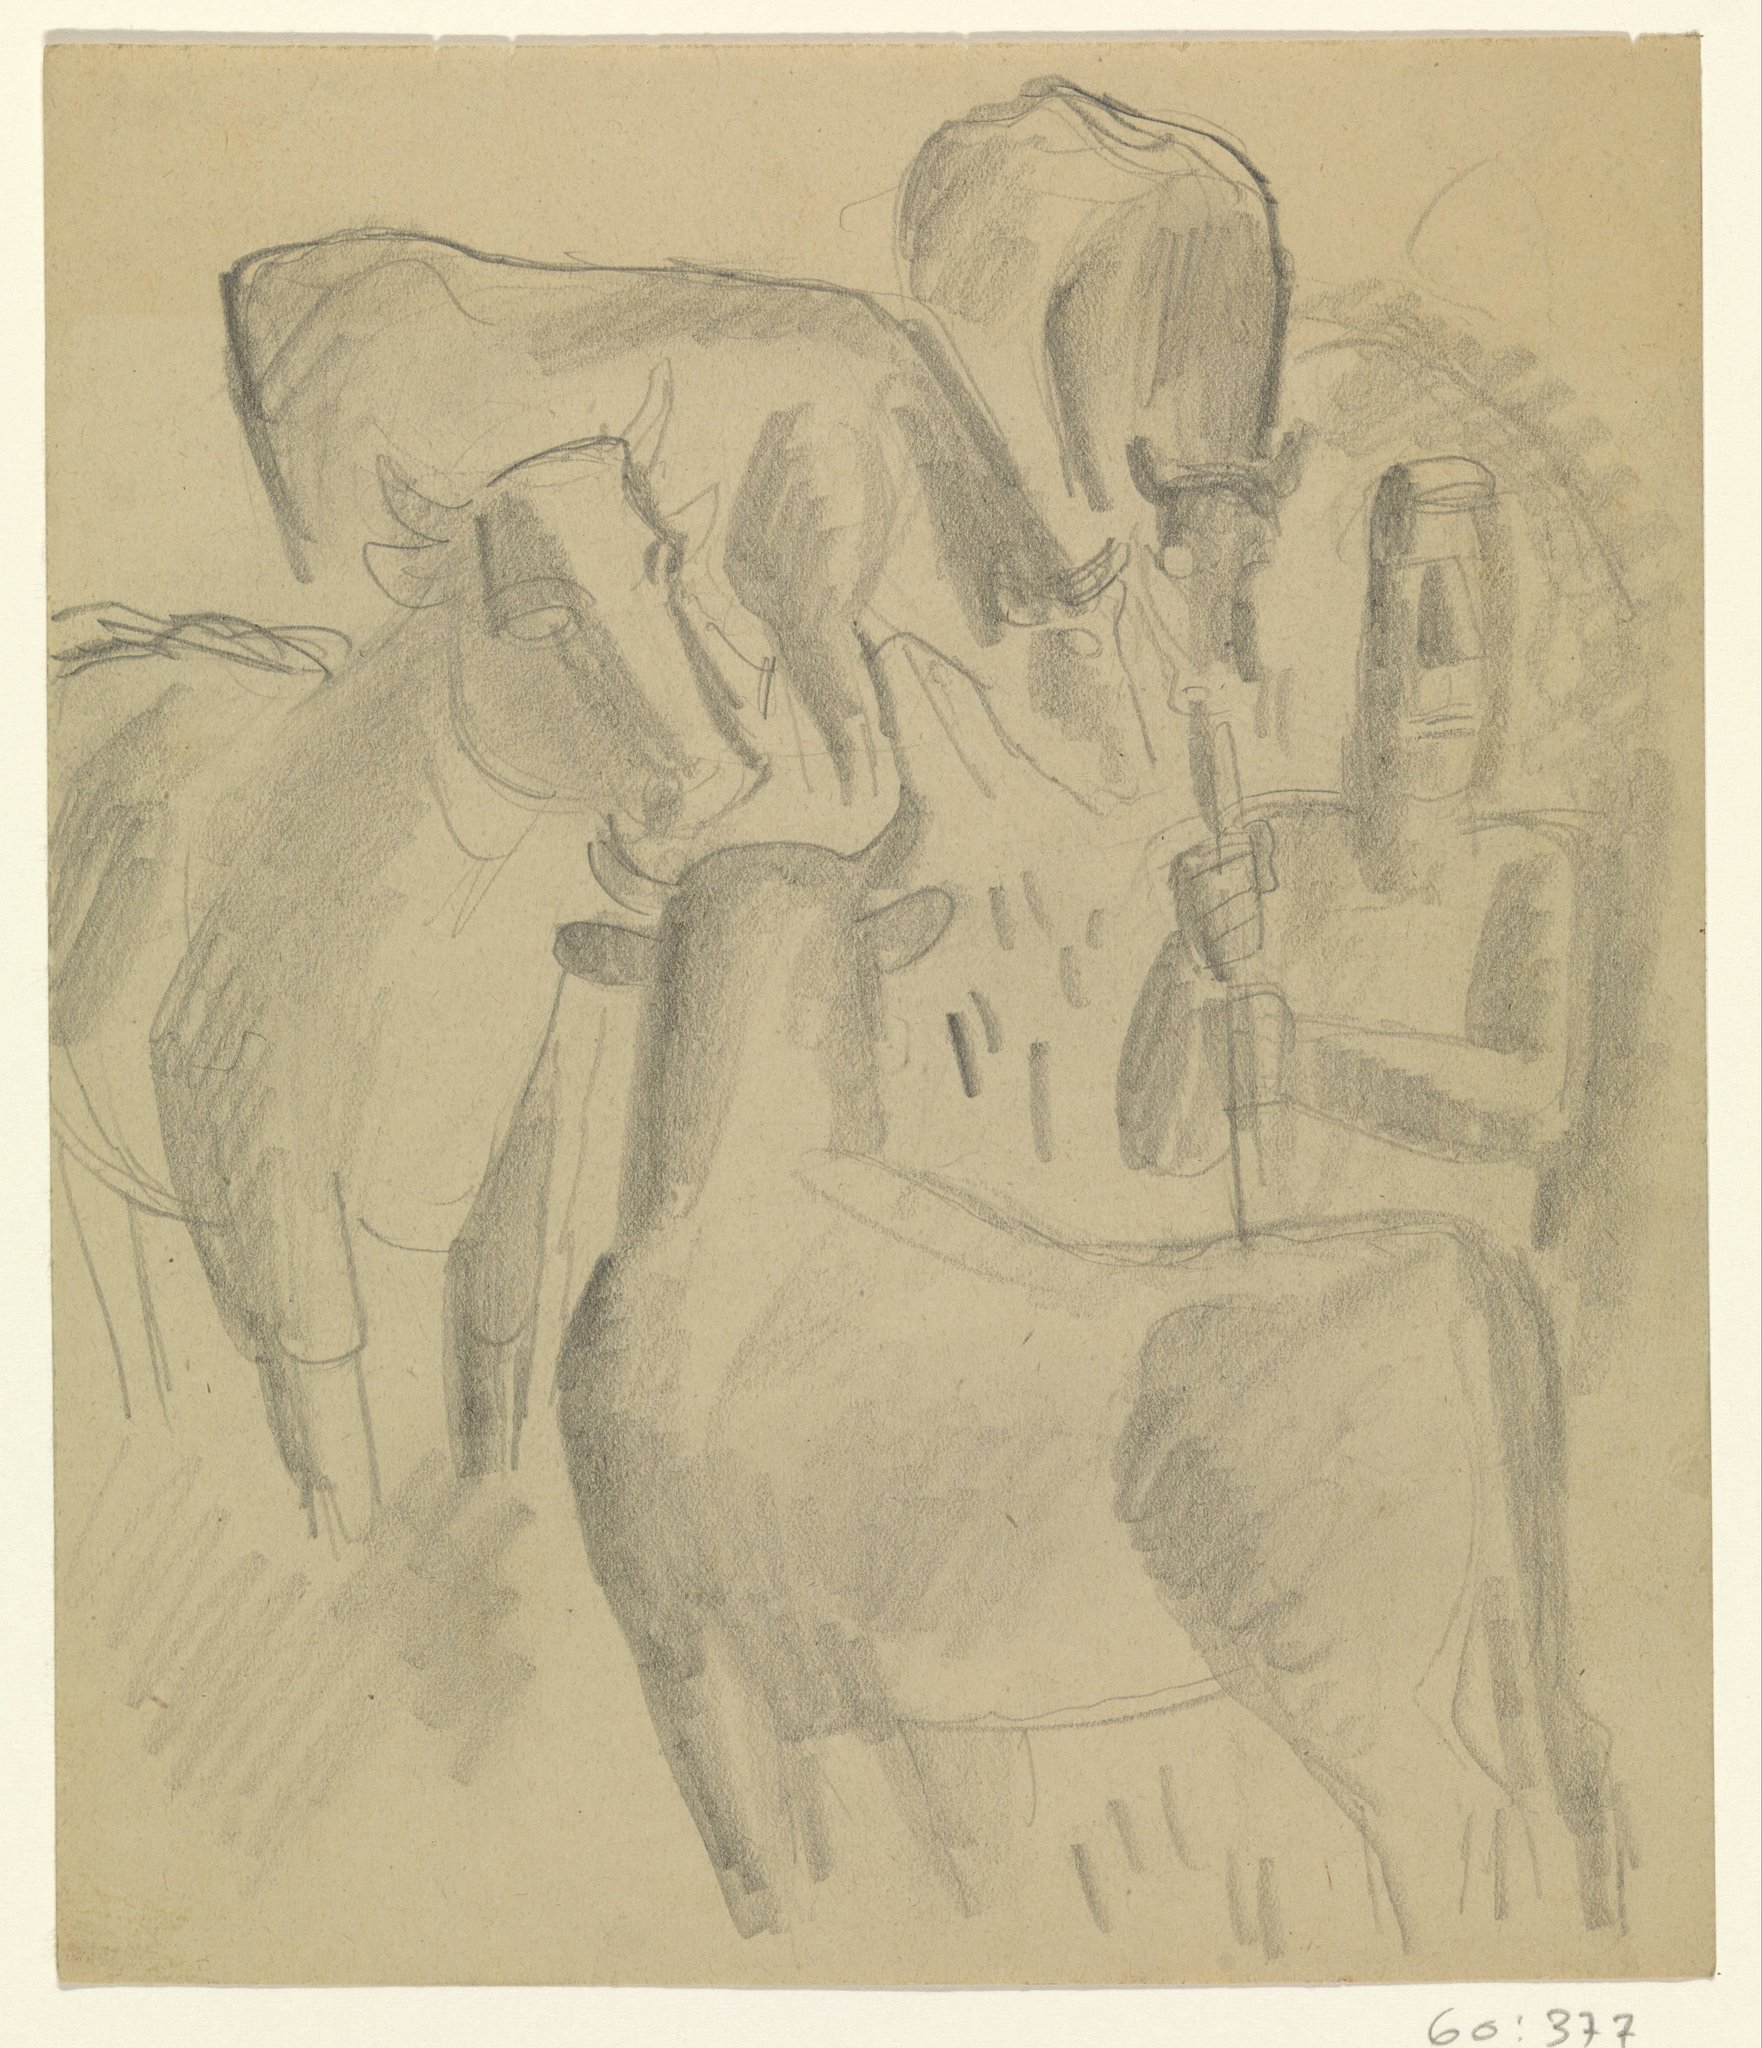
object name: drawing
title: Boer met vier koeien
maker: leo gestel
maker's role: draughtsman, print maker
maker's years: 1881-1941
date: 1891-1941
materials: paper, pencil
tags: cow, farmers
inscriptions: collector's mark: Lugt 2228